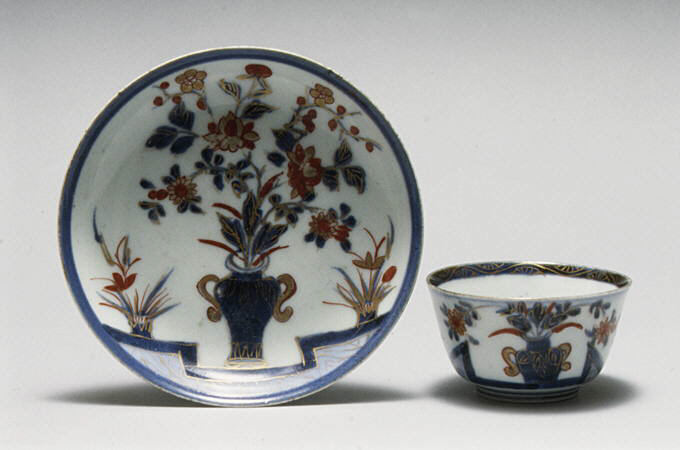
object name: teabowl and saucer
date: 1701-1733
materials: hard paste porcelain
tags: flowers